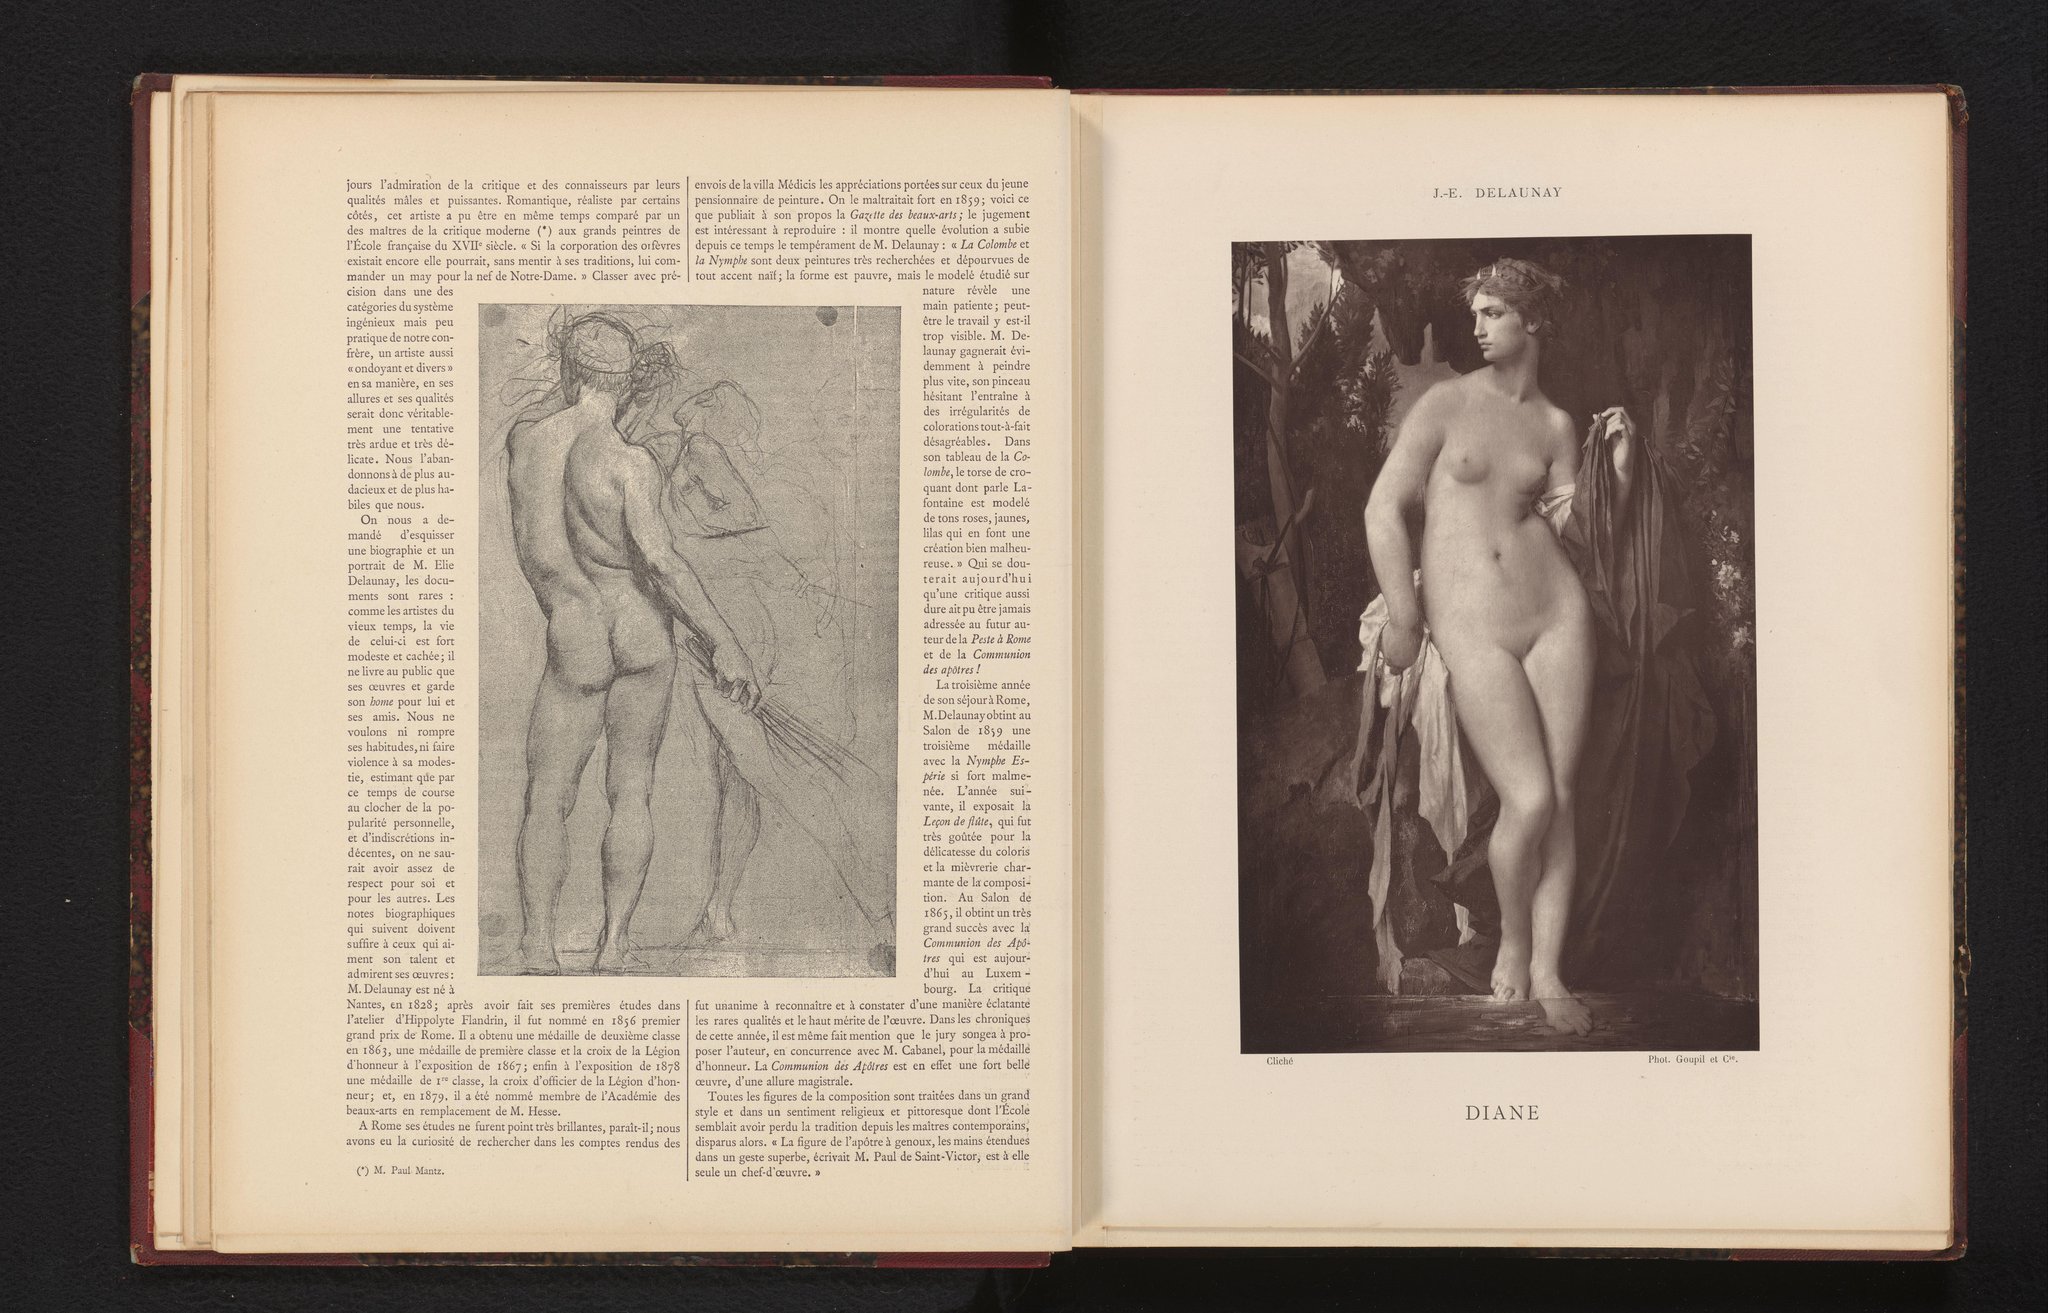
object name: page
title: Diane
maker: jules-élie delaunay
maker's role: painter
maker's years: 1828-1891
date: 1878-1883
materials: paper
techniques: woodburytype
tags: diana bathing